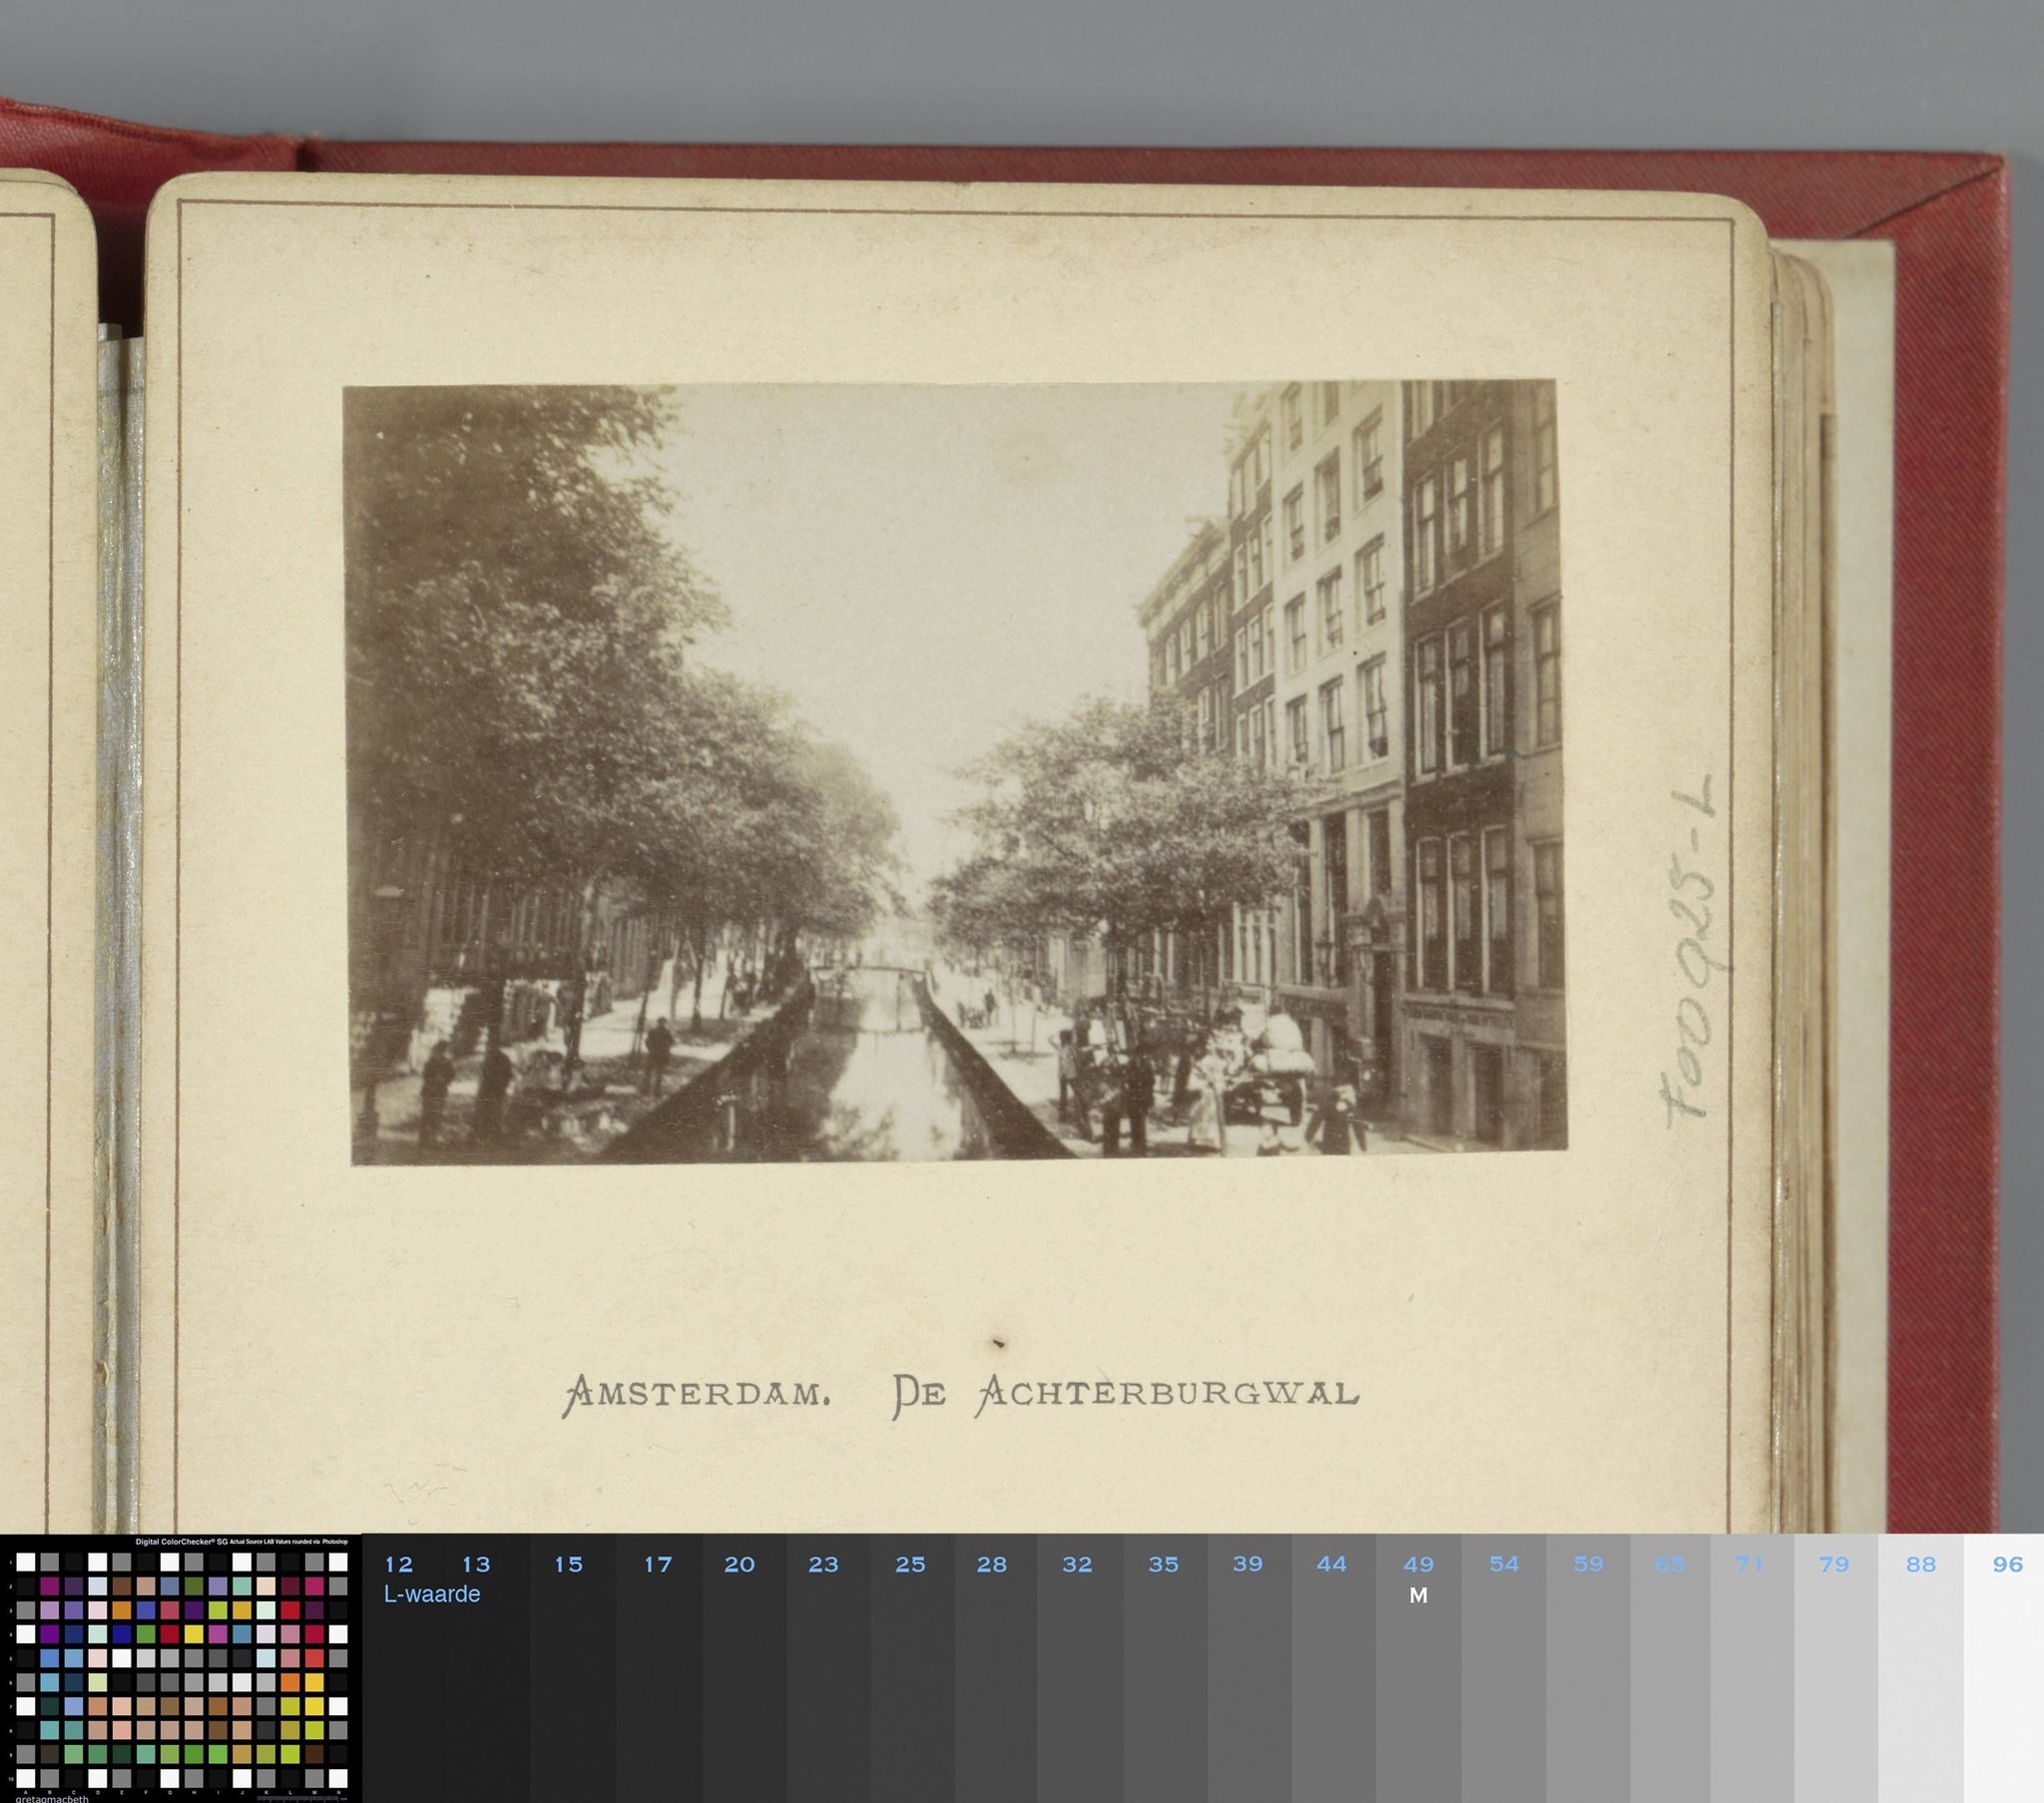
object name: photograph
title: Amsterdam. De Achterburgwal.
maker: andries jager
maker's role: publisher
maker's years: 1825-1905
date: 1860-1900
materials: cardboard, photographic support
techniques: albumen print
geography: amsterdam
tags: canals, waters (in city)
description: Onderdeel van Fotoalbum met opnames van steden in Noord- en Zuid-Holland en Utrecht.